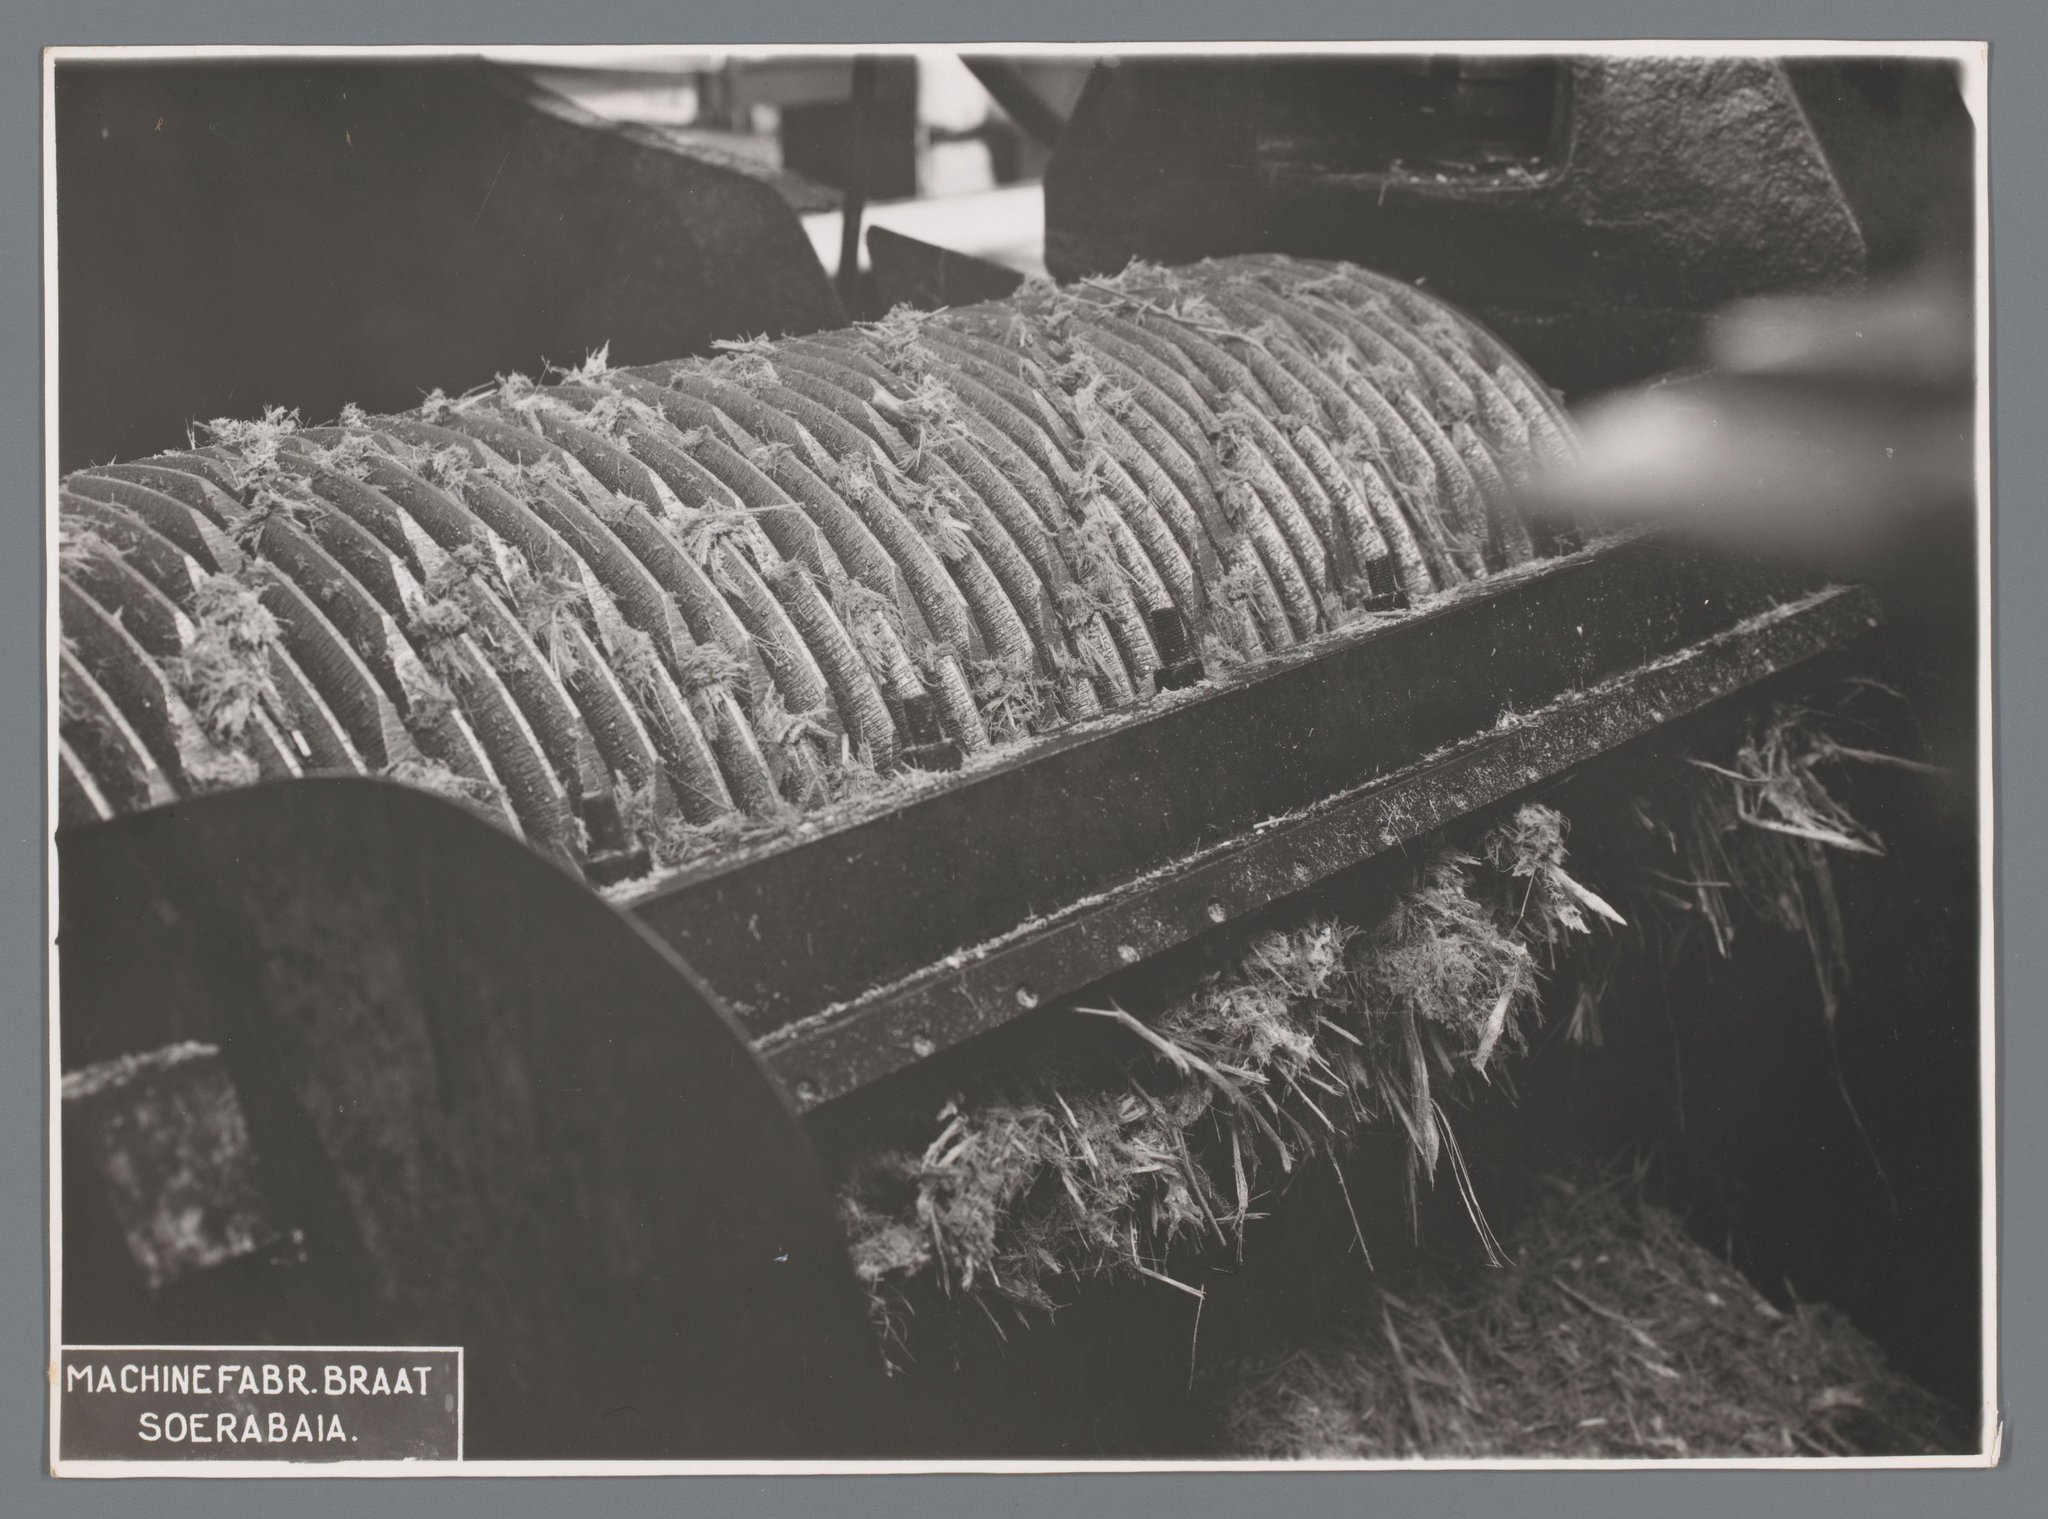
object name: photograph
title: Canecutter in bedrijf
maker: Anonymous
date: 1911-1938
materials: photographic support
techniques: gelatin silver print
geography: java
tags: colonial system, machines; parts of machines; tools and appliances, (non-fruit) products of plants or trees: sugarcane, interior of industrial structures (regardless of the materials processed or the products made, java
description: Canecutter in bedrijf op de Suikerfabriek Pesantren bij Kediri. Onderdeel van de multomap met foto's van machines van de N.V. Machinefabriek Braat te Soerabaja bestemd voor de Nederlandse suikerindustrie op Java, uit de periode 1917-1938.